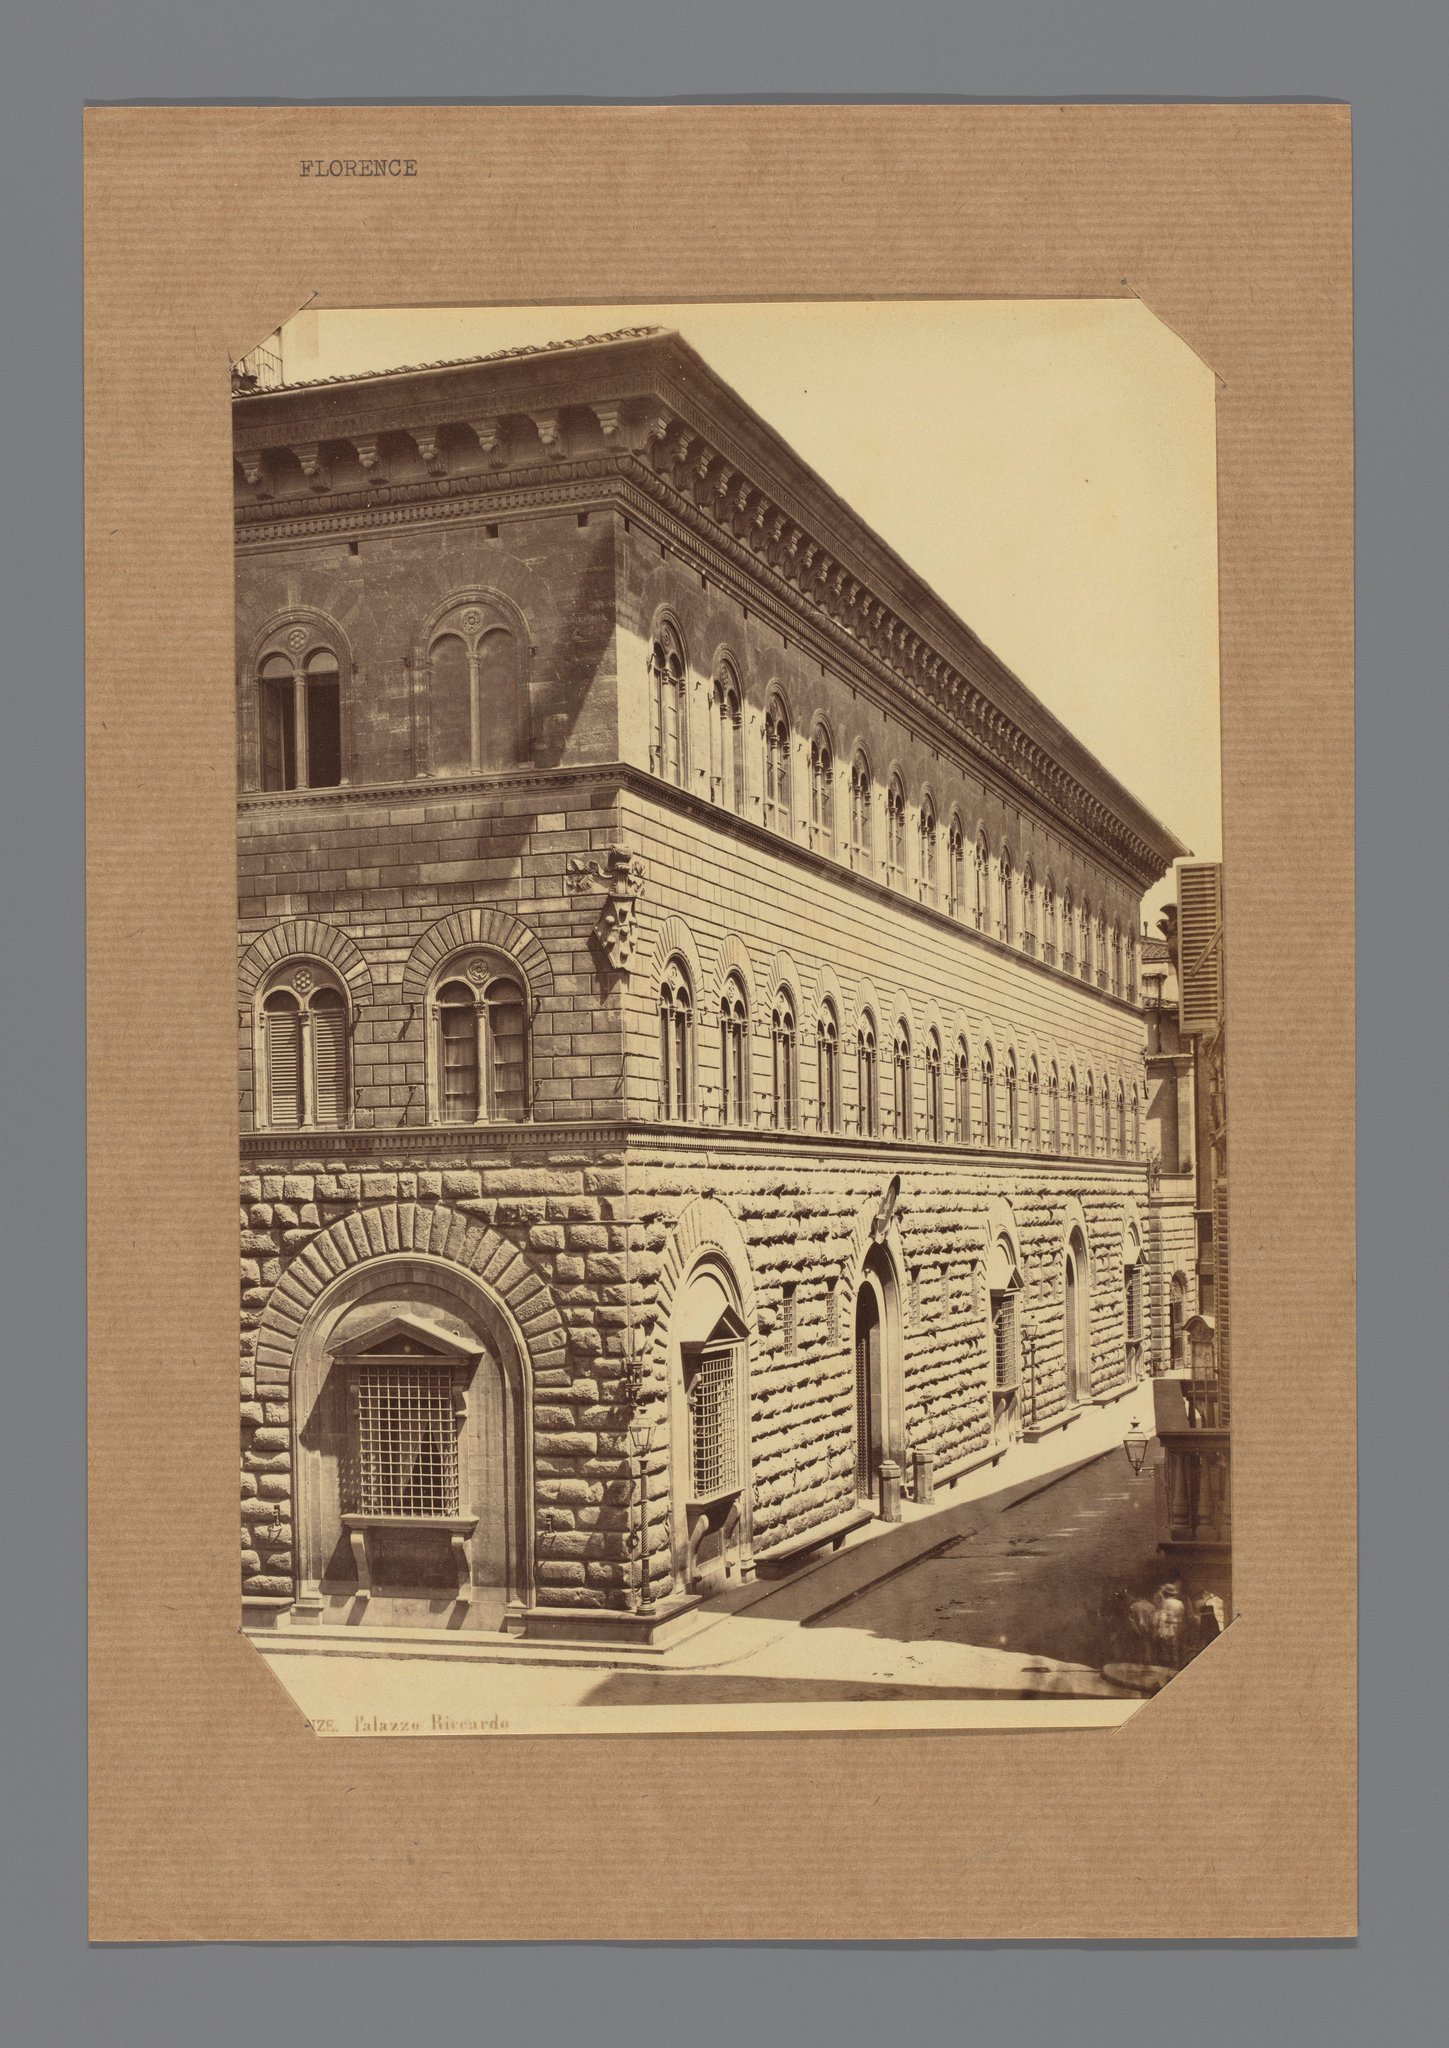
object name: photograph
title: Italië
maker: Anonymous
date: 1880-1910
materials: photographic support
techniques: albumen print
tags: italy